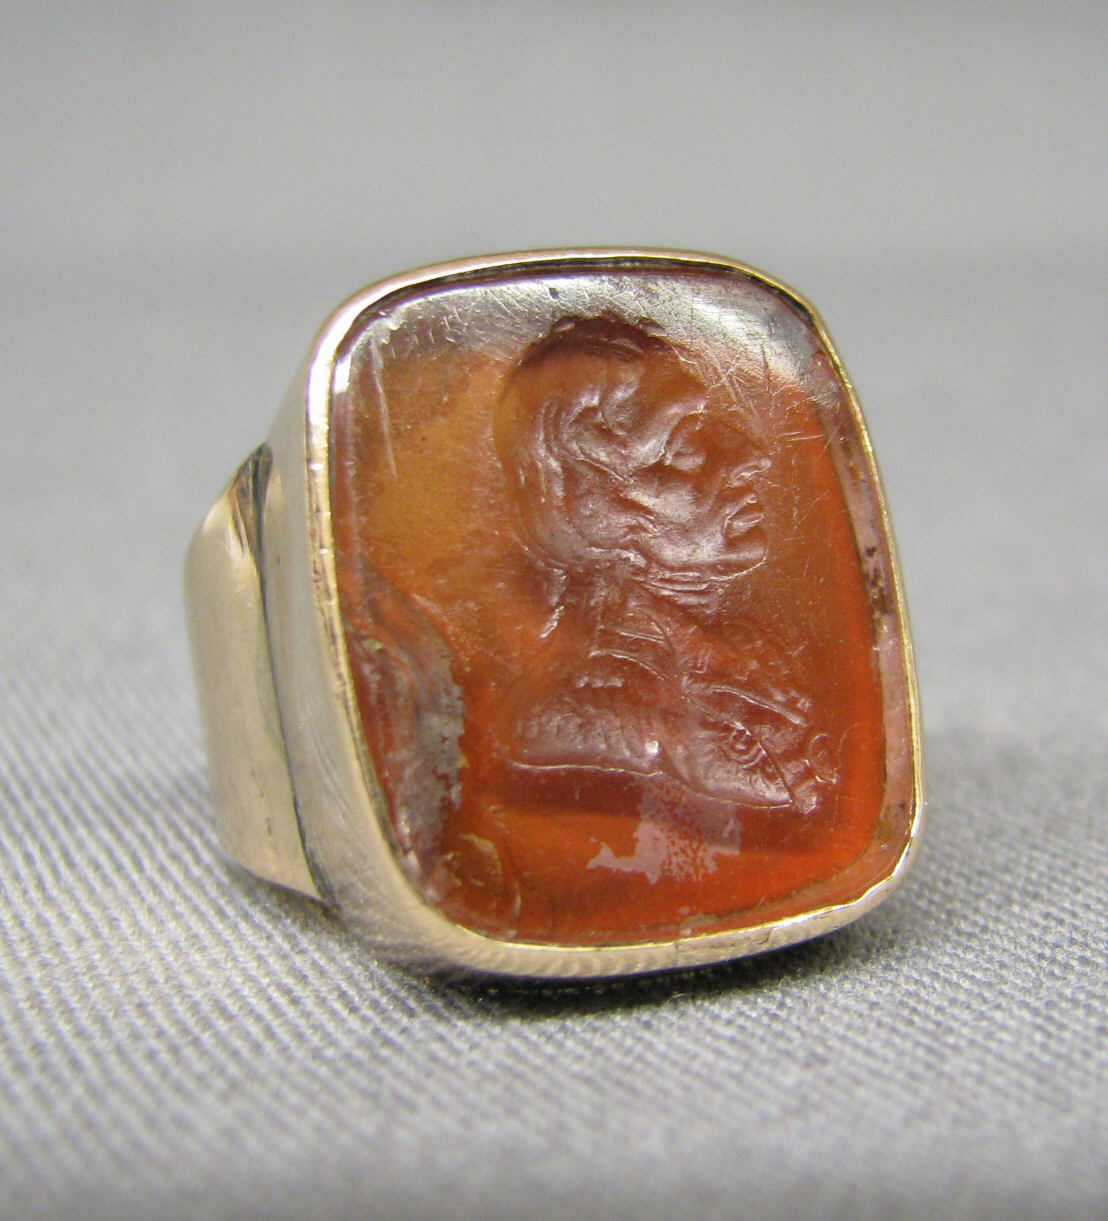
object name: ring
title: Bust of Horatio Nelson, 1st Viscount Nelson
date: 1805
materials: glass, gold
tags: men,profiles